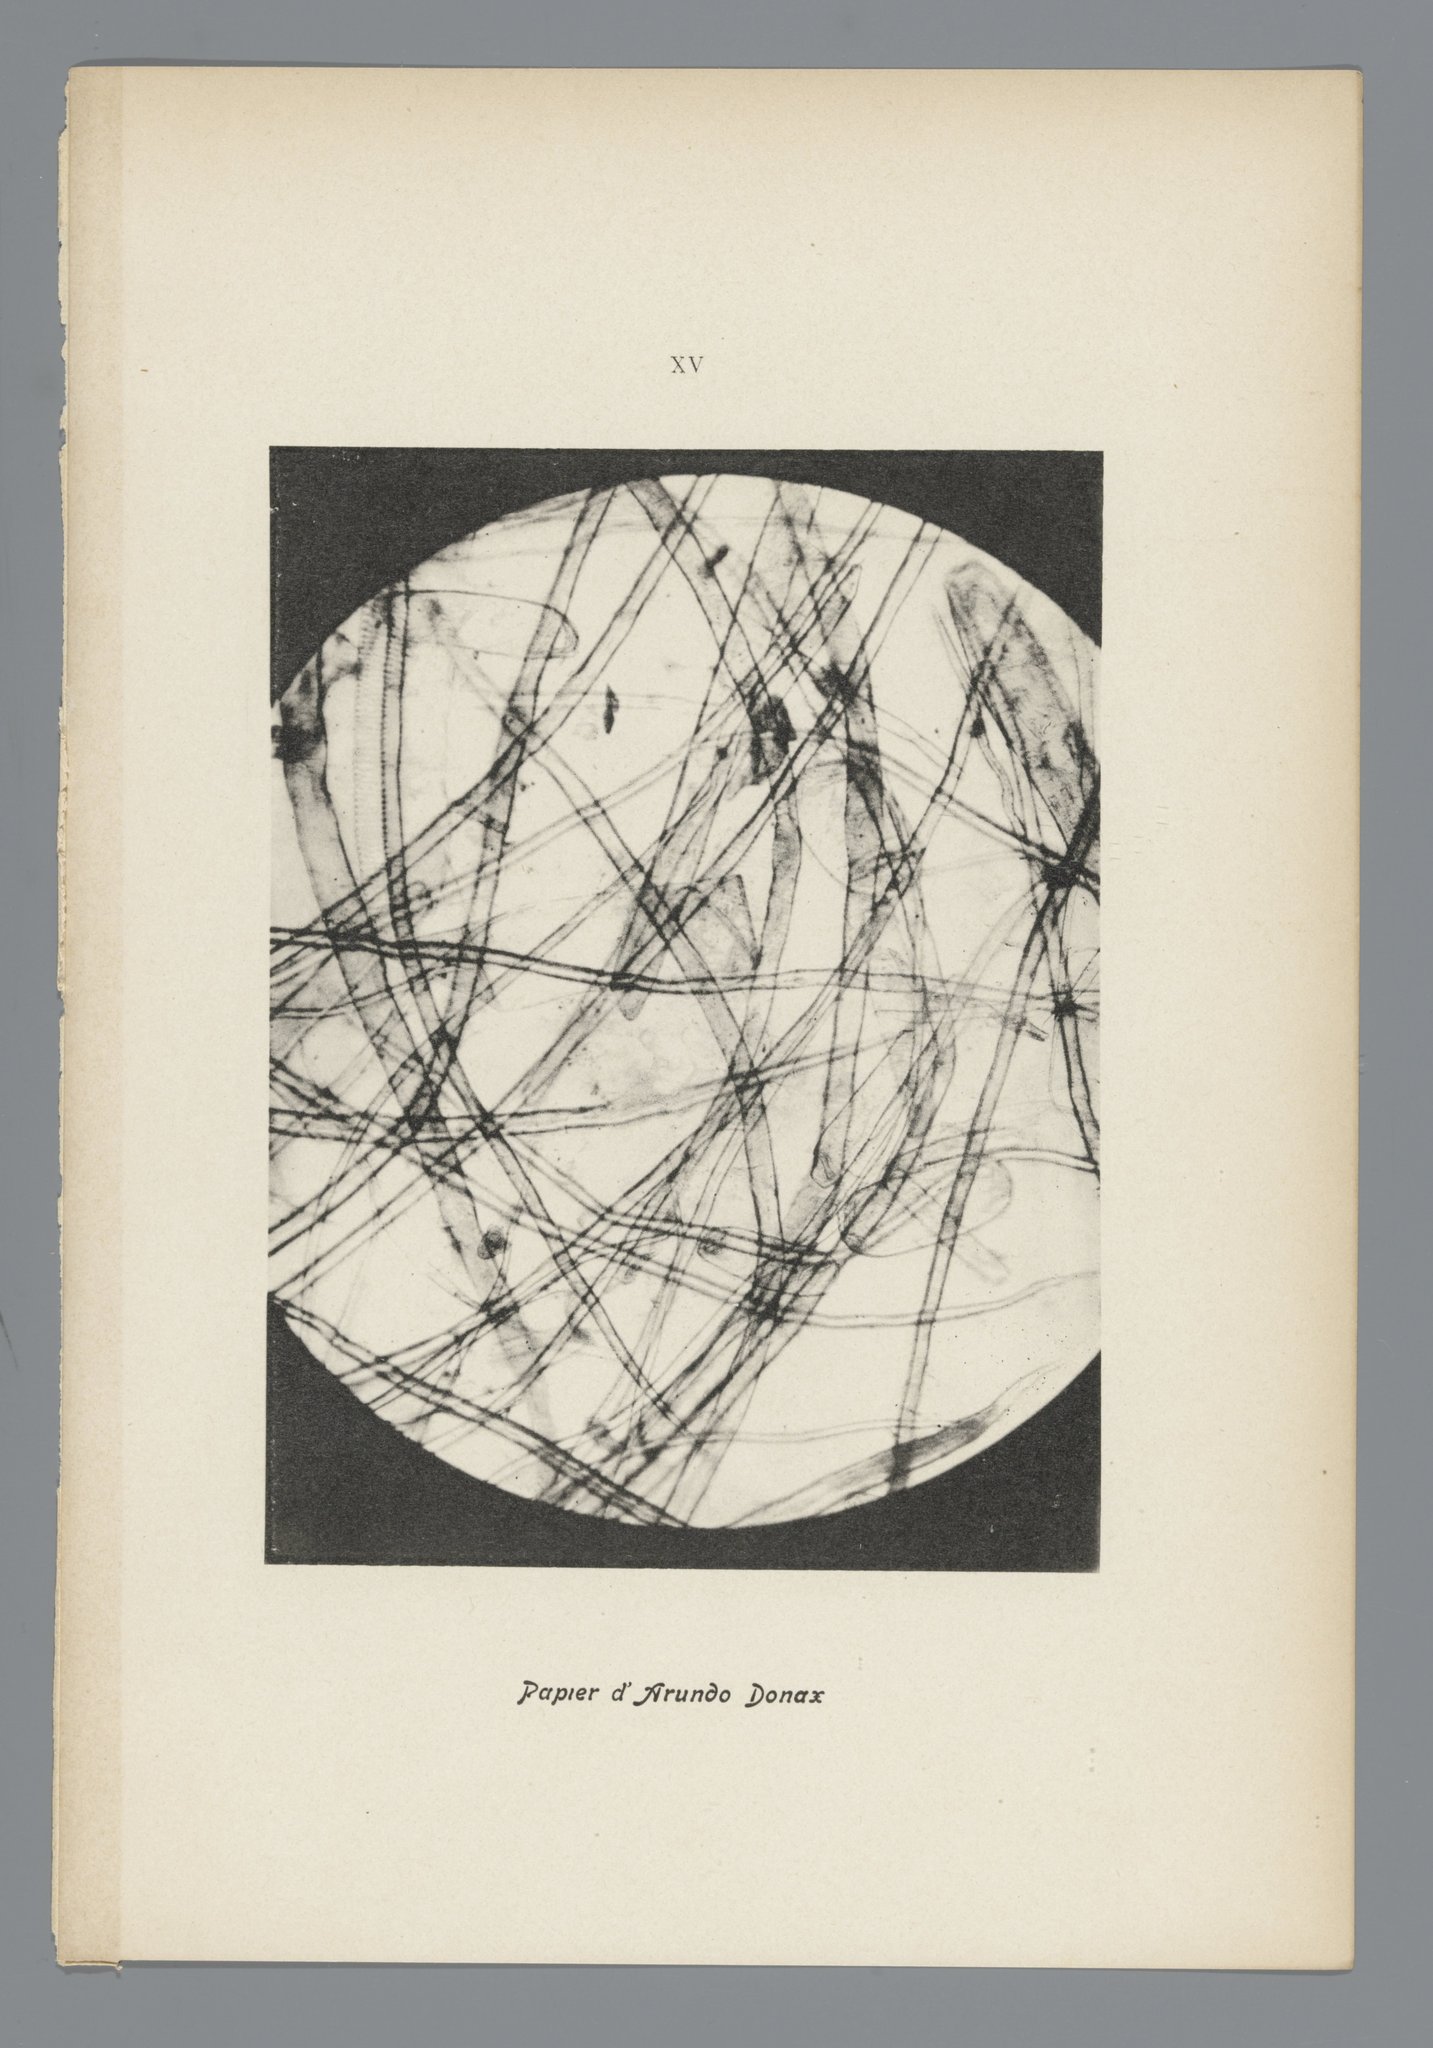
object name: photograph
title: XV Papier d'Arundo Donax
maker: Anonymous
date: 1900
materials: ink, paper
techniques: photograph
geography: france